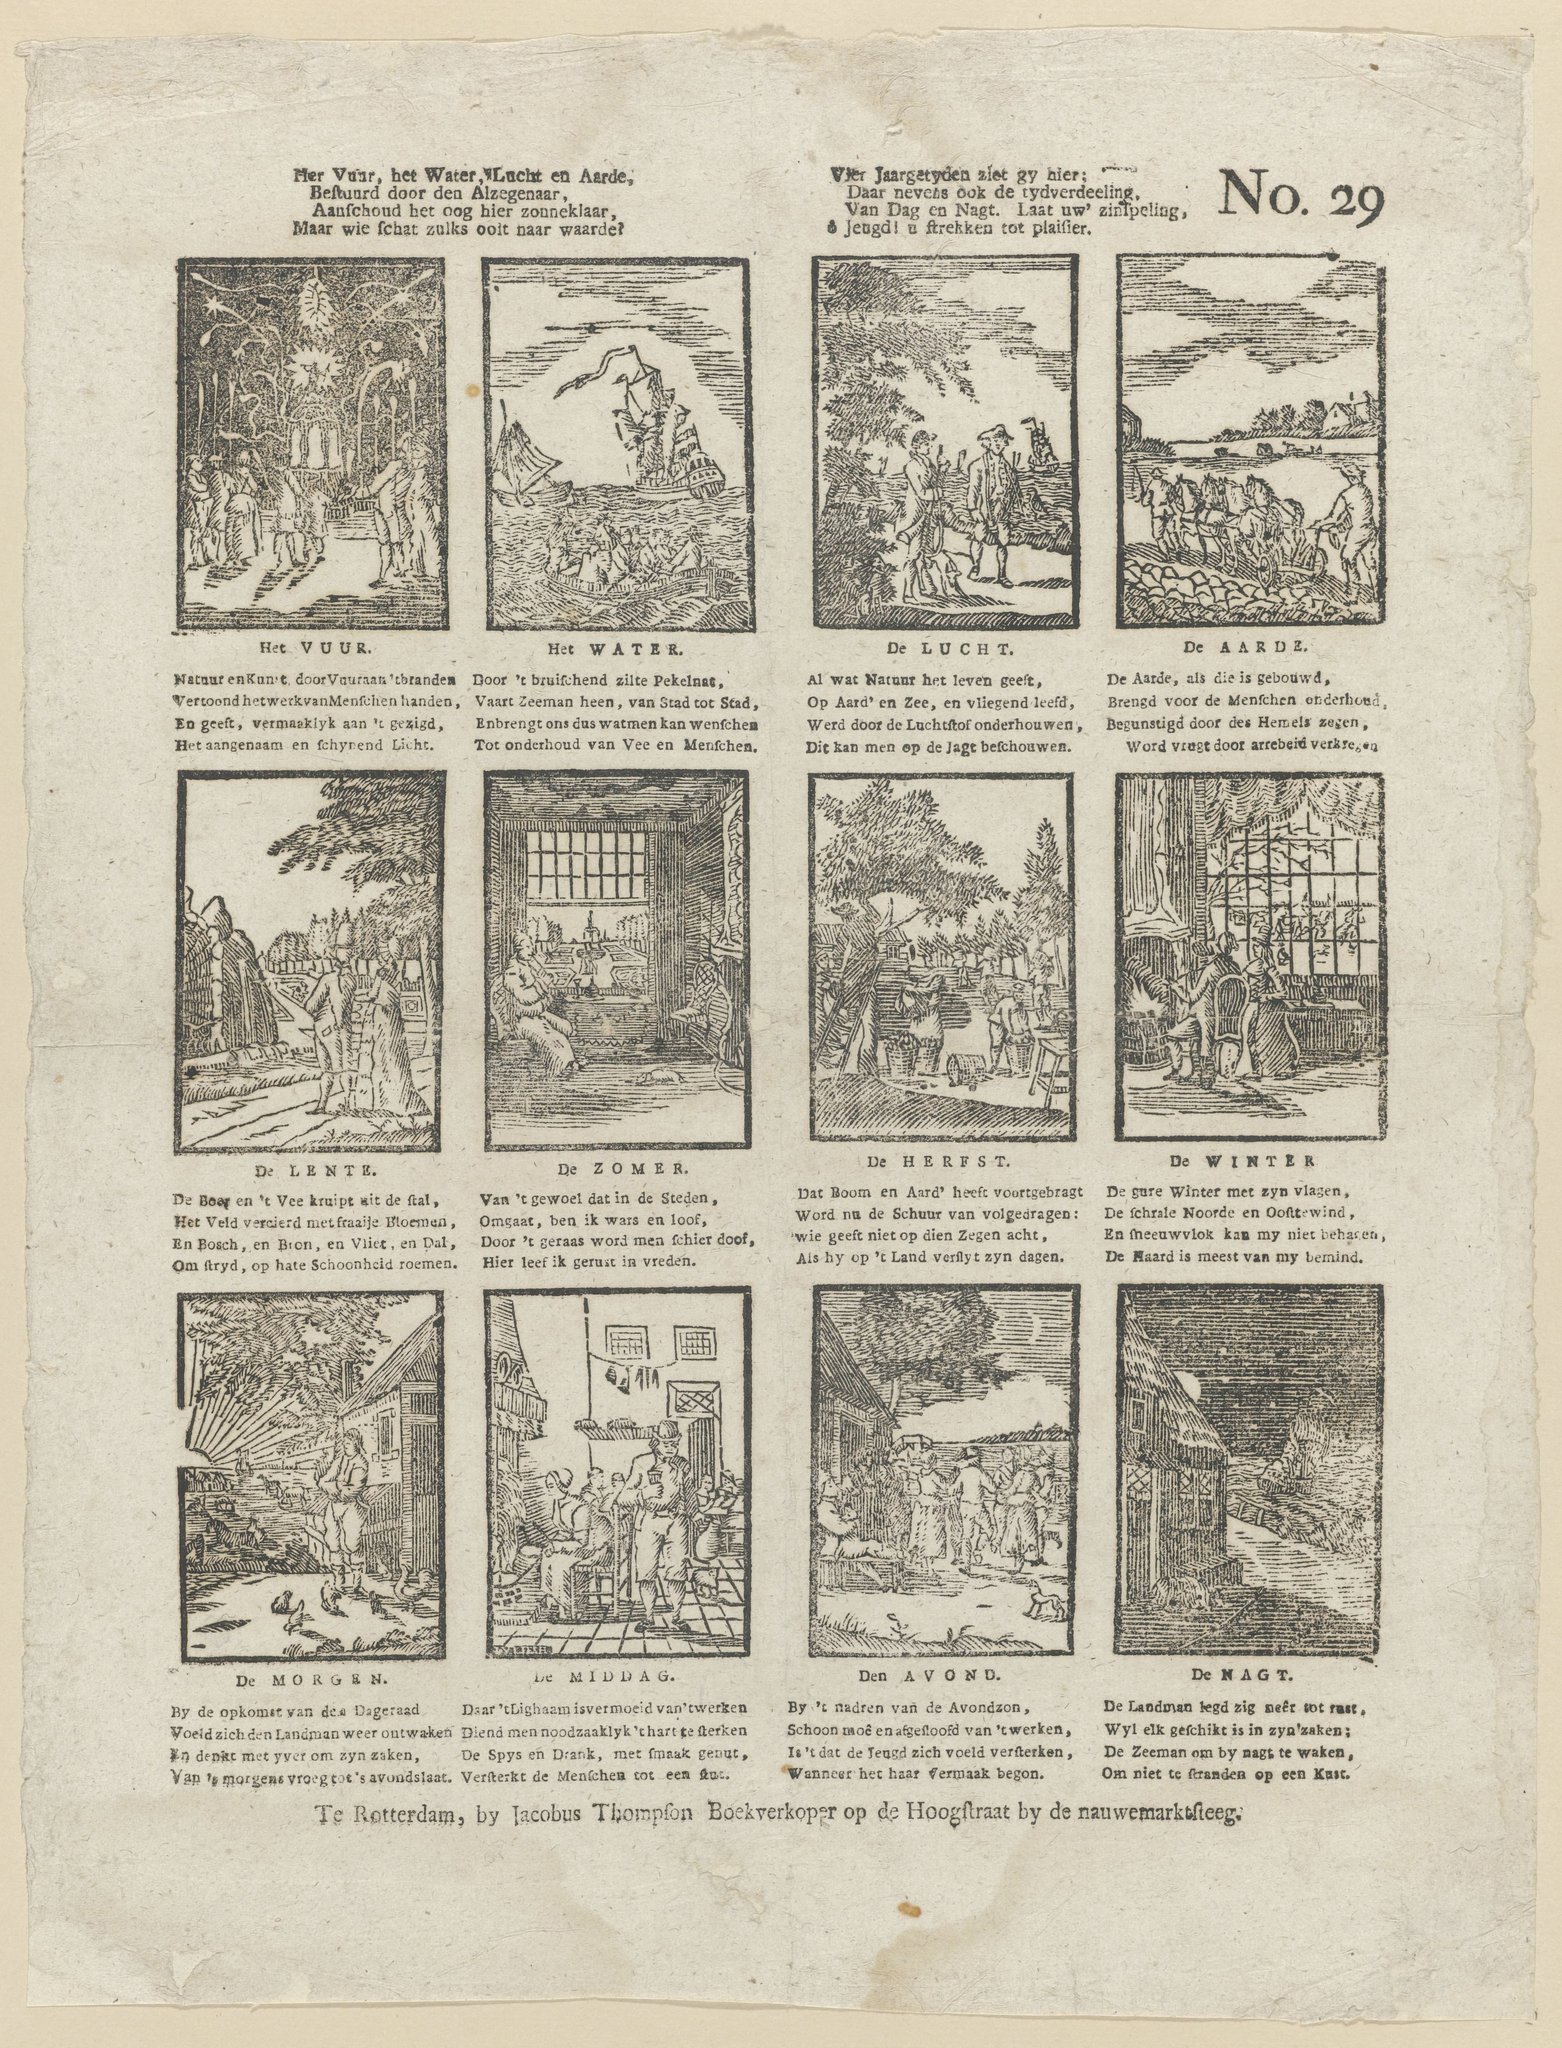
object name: print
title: Her vuur, het water, lucht en aarde, / Bestuurd door den Alzegenaar (...)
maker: jacobus thompson (i)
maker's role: publisher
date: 1791-1812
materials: paper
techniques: letterpress printing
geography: rotterdam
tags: the four elements, and ether, the fifth element, evening, the four seasons of the year ~ other concepts (e.g. biblical scenes), morning, afternoon, night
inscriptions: collector's mark: Lugt 2760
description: Blad met 12 voorstellingen van de vier elementen, de vier jaargetijden en de vier getijden van de dag. Onder elke afbeelding een titel en een vierregelig vers. Genummerd rechtsboven: No. 29.